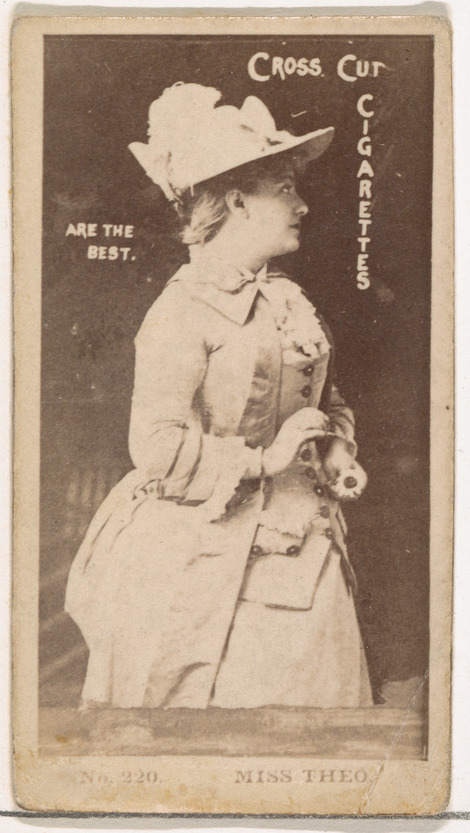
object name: print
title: Card Number 220, Miss Theo, from the Actors and Actresses series (N145-2) issued by Duke Sons & Co. to promote Cross Cut Cigarettes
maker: w. duke, sons & co.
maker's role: publisher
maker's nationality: american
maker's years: 1870-1920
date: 1880-1889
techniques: albumen silver print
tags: women,actresses